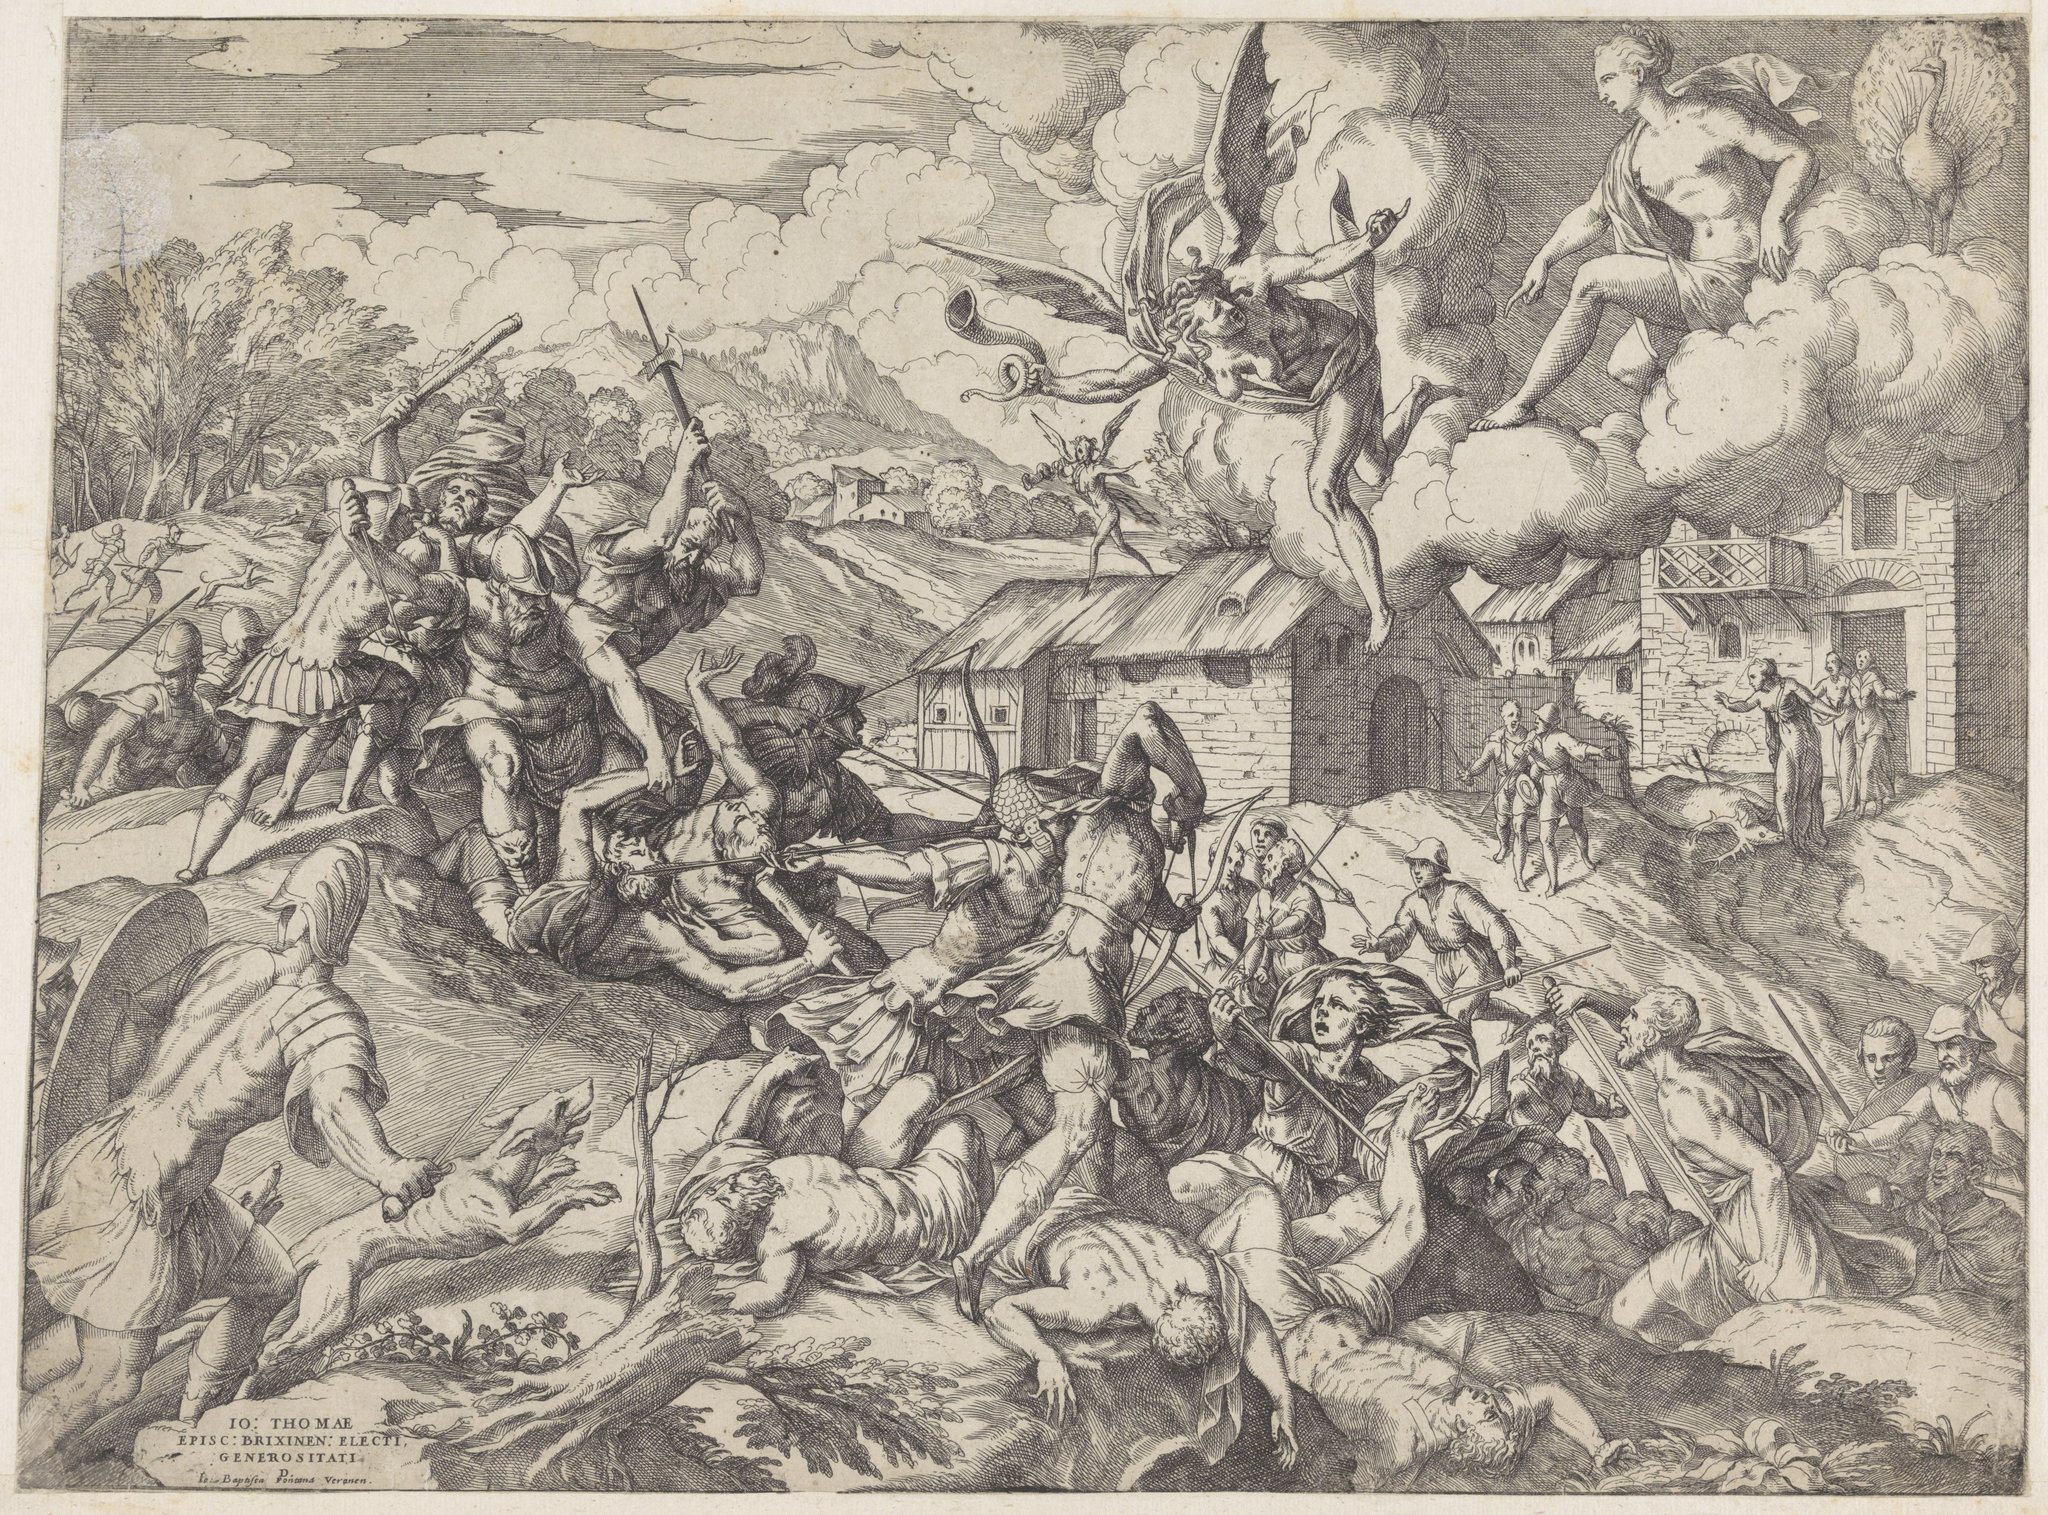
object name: print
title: Soldaten van Aeneas vechten met dienaren van koning Latinus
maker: giovanni battista fontana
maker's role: draughtsman, painter, print maker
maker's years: 1524-1587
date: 1535-1587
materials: paper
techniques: etching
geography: italy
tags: (story of) juno (hera), the trojans with king latinus, disagreement, discord; 'discordia' (ripa)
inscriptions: collector's mark: Lugt 240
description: Landschap met de soldaten van Aeneas in gevecht met de dienaren van koning Latinus. Rechtsboven verschijnen Juno en de personificatie van onenigheid.